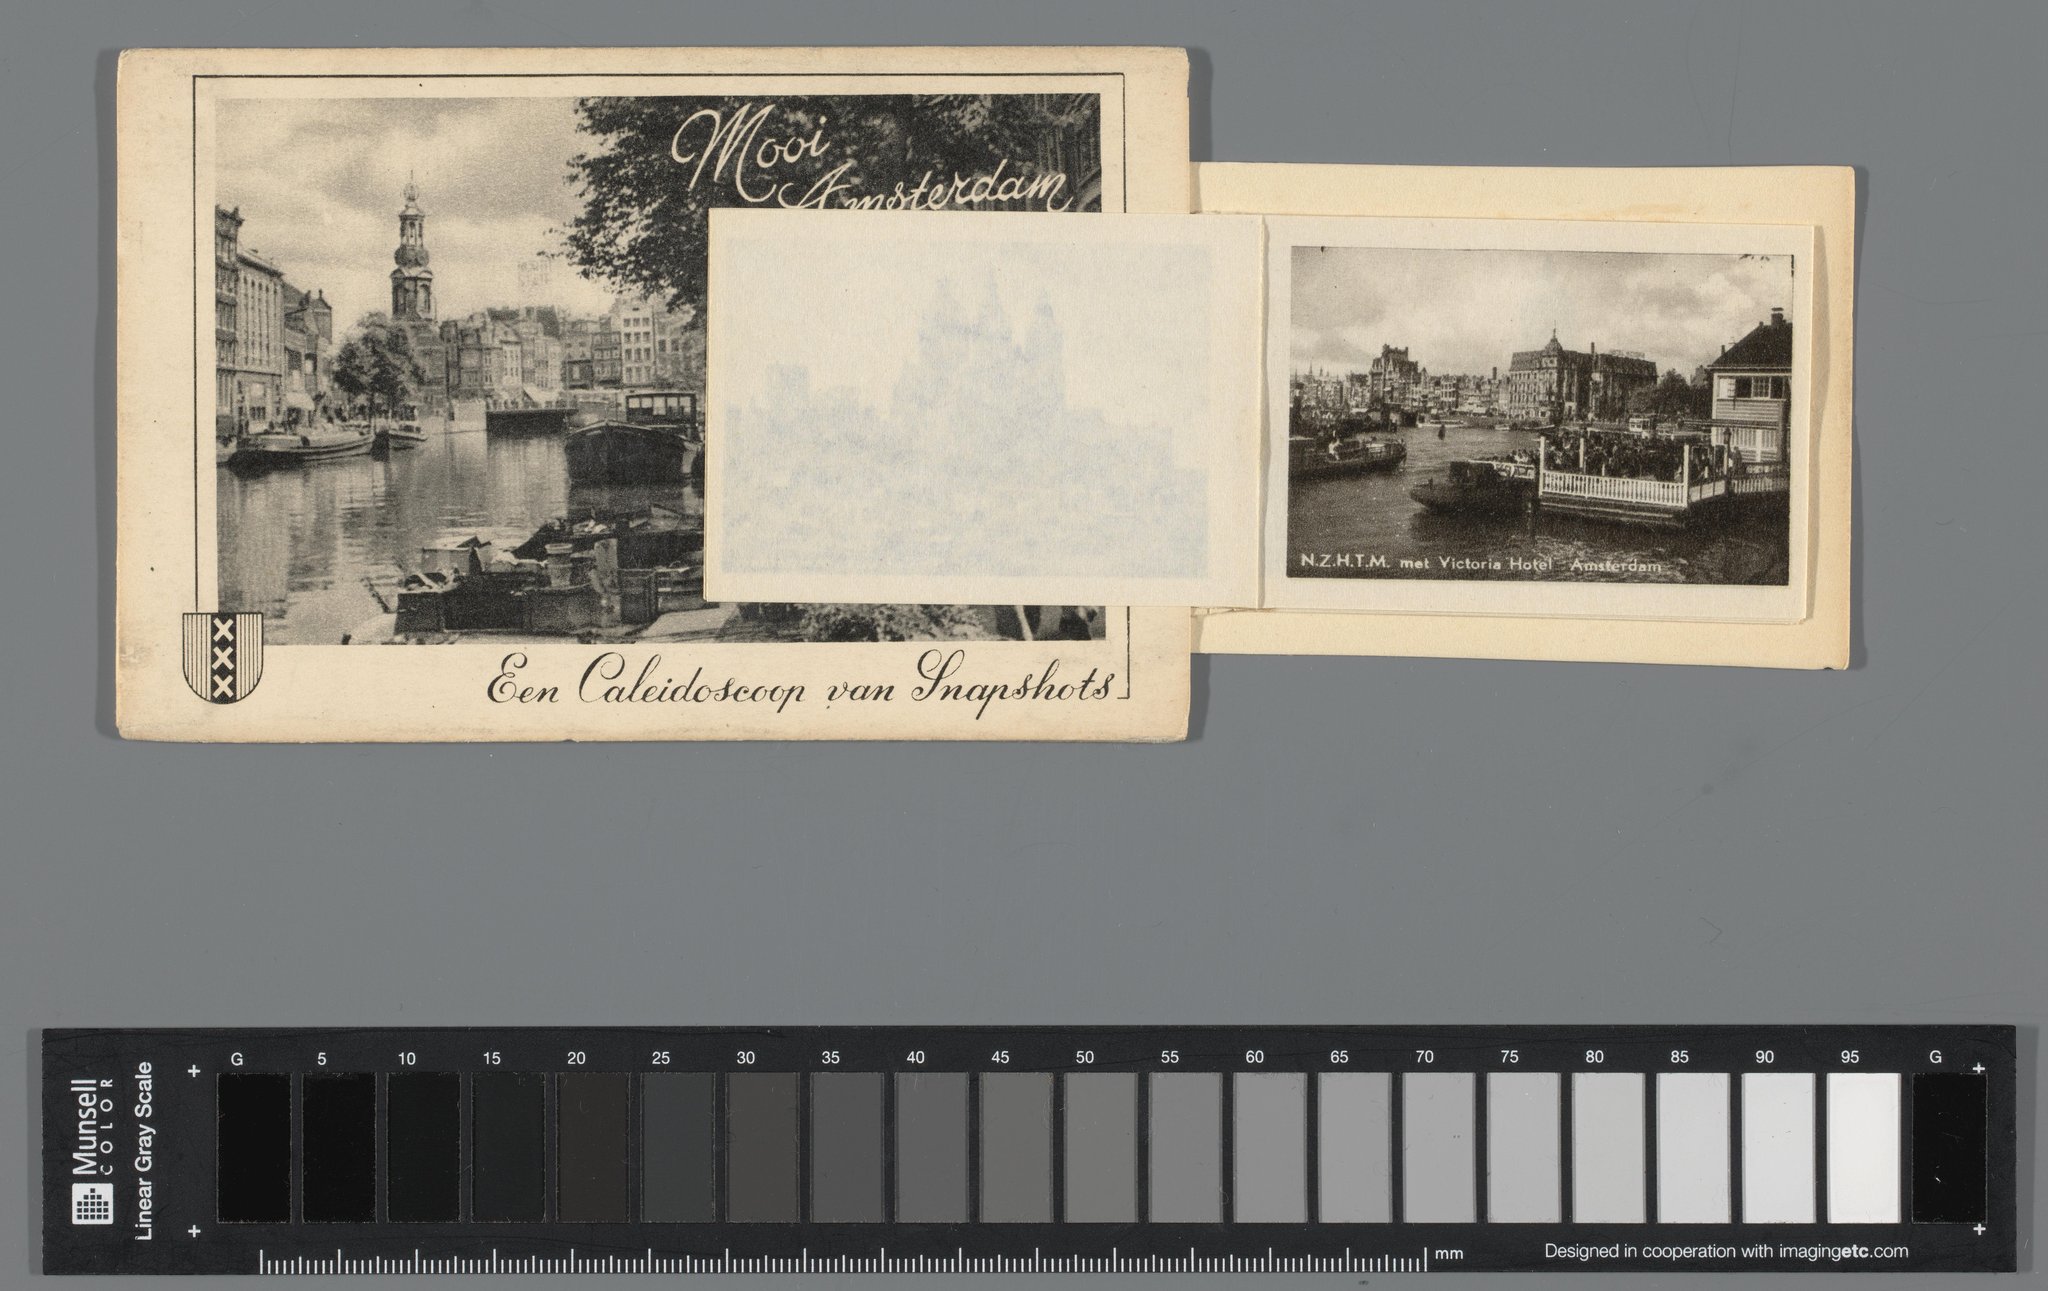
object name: photomechanical print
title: N.Z.H.T.M. met Victoria Hotel Amsterdam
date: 1920-1950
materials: paper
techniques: rotogravure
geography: eemnes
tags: canals, waters (in city), hotel, hostelry, inn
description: Deze prent maakt deel uit van een omslag met tien prenten.